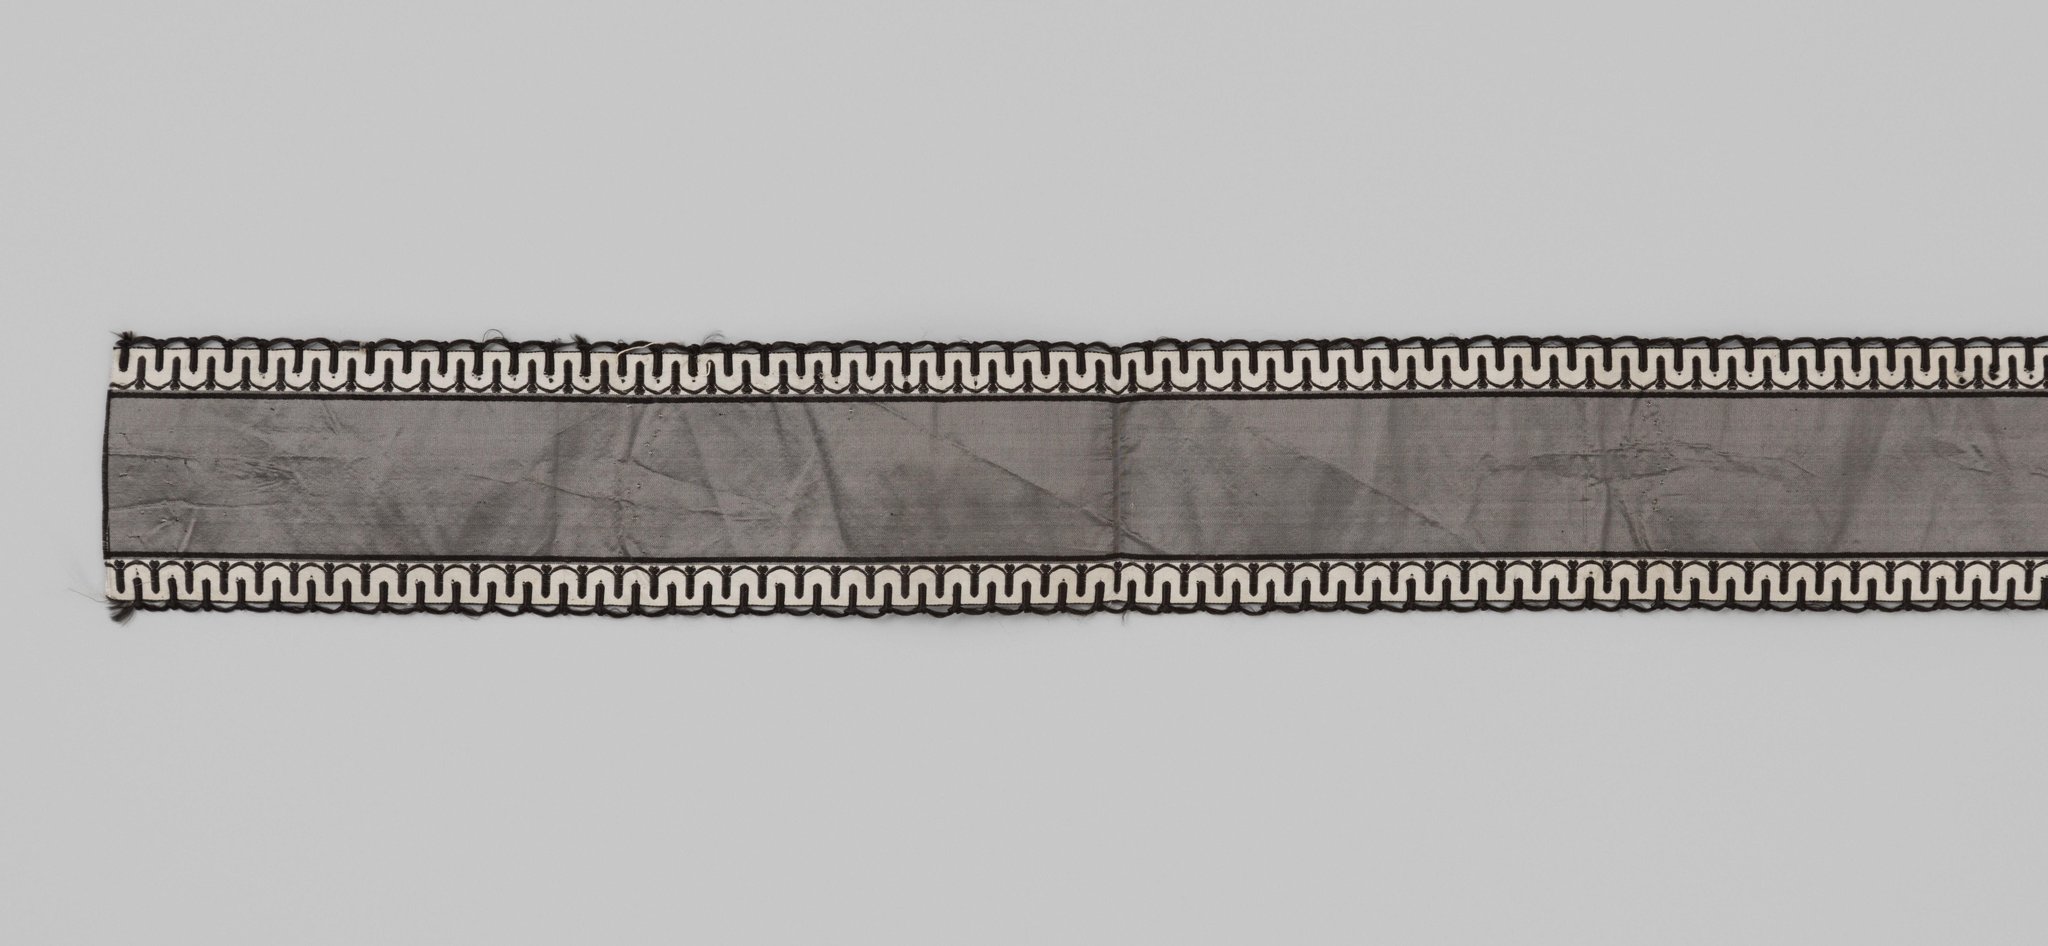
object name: galloon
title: Lint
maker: Anonymous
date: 1800-1899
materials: metal thread, silk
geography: europe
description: Een lint met zwarte en zilverdraad met zwart-witte rand aan beide zijden met lussen van zwart zijdedraad, met speldenprikken.